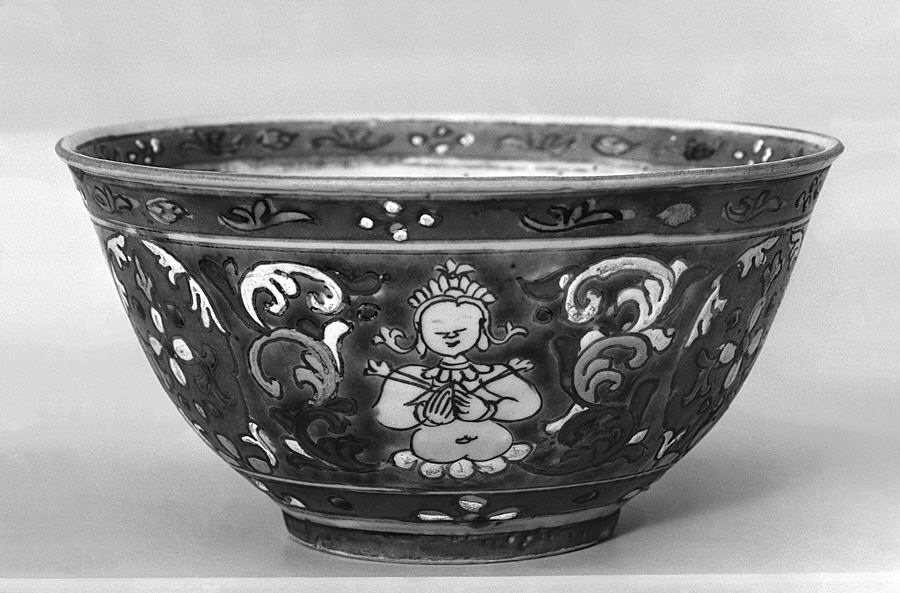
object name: bowl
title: Bowl with Thai mythical figures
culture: chinese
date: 1801-1900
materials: enamel, porcelain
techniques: overglaze, painting, polychrome